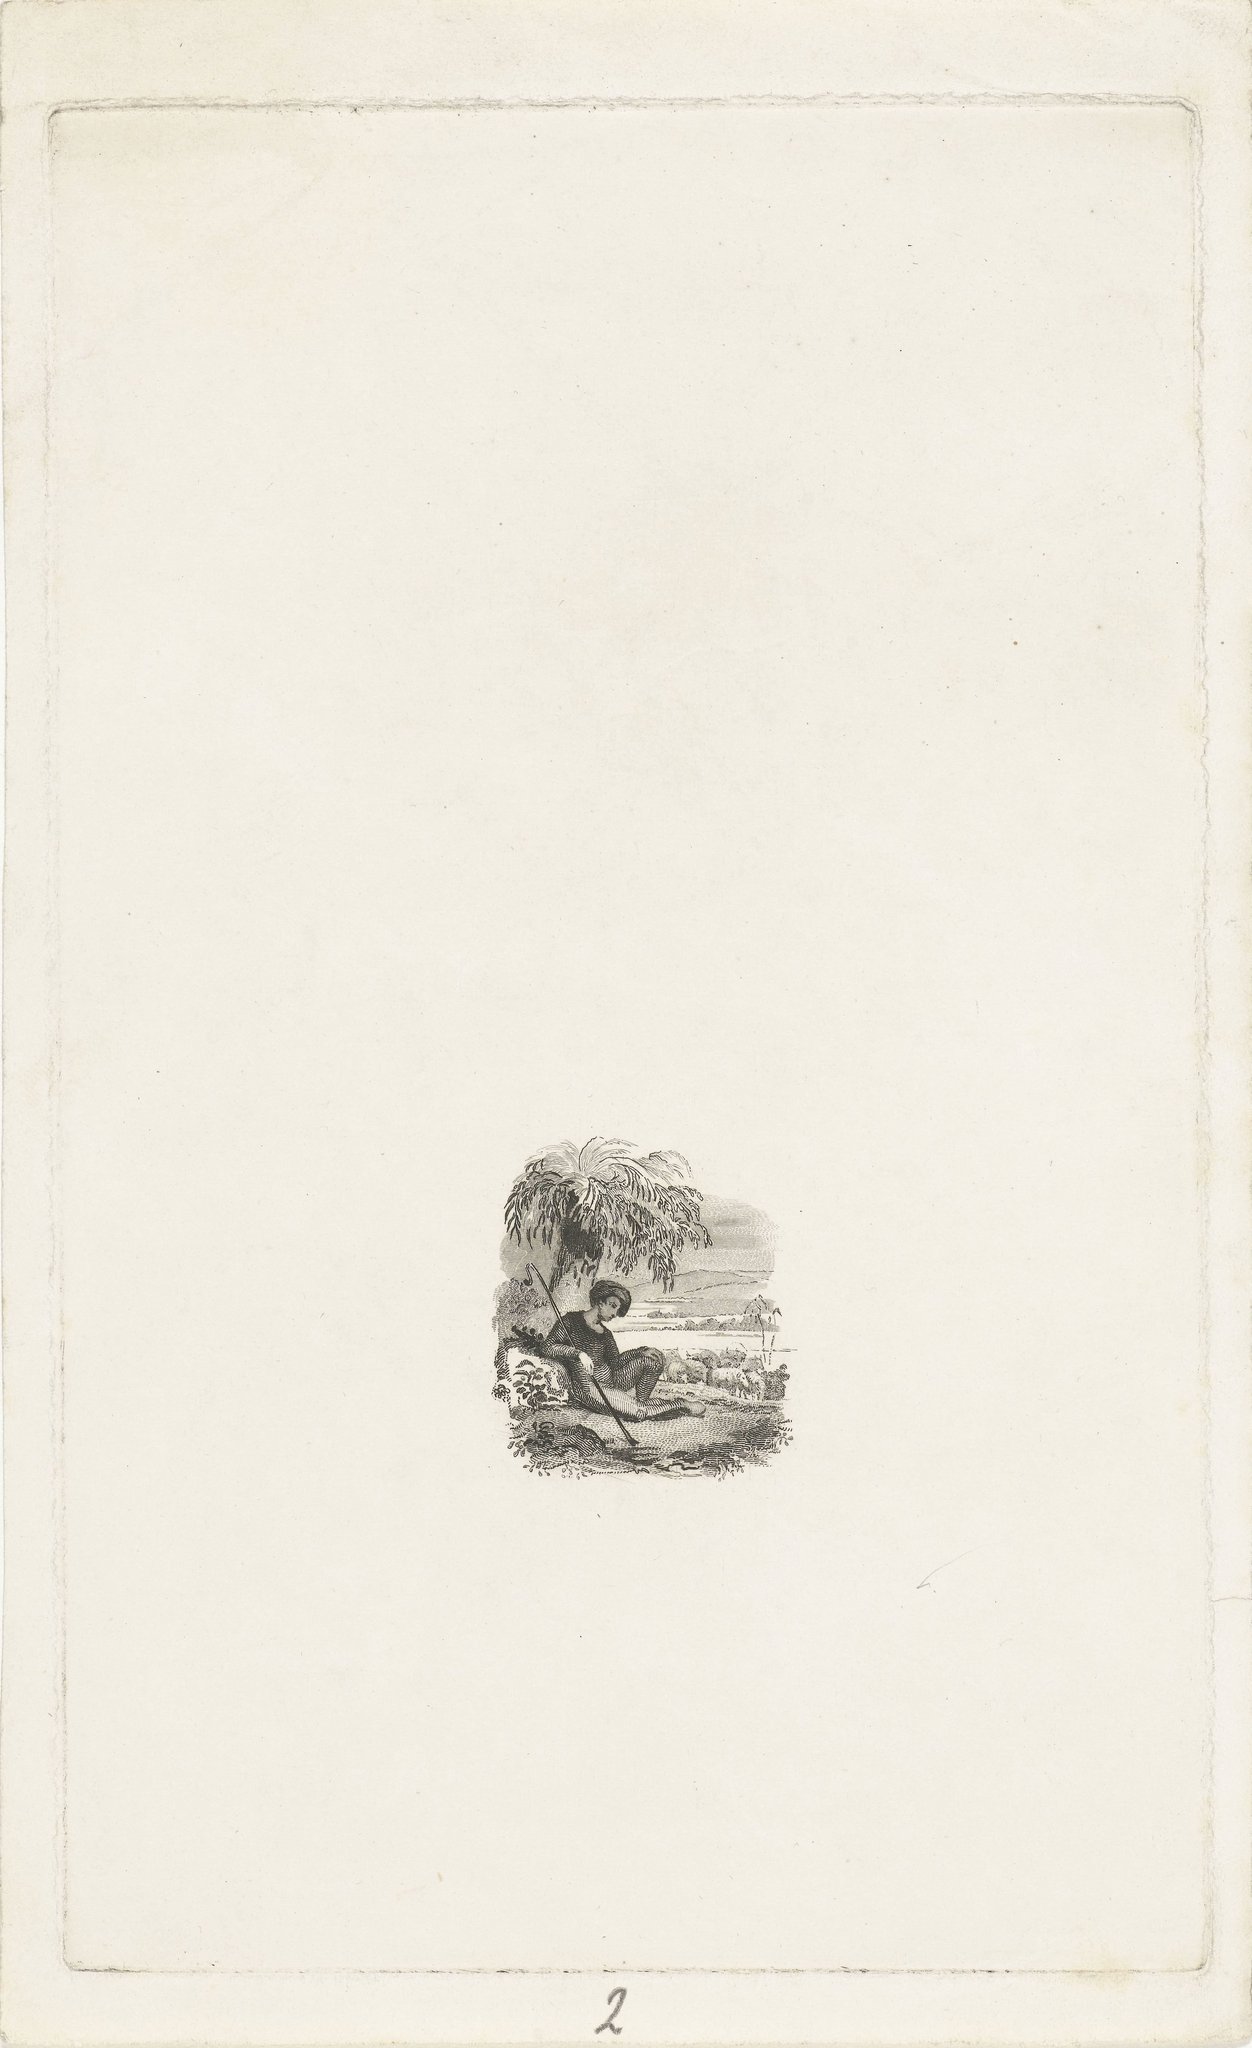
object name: book illustration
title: Schaapherder rust uit onder een boom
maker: henricus wilhelmus couwenberg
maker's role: draughtsman, print maker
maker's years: 1814-1845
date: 1830-1845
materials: paper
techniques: engraving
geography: amsterdam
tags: herding, herdsman, herdswoman, shepherd, shepherdess, cowherd, etc.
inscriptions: collector's mark: Lugt 2228